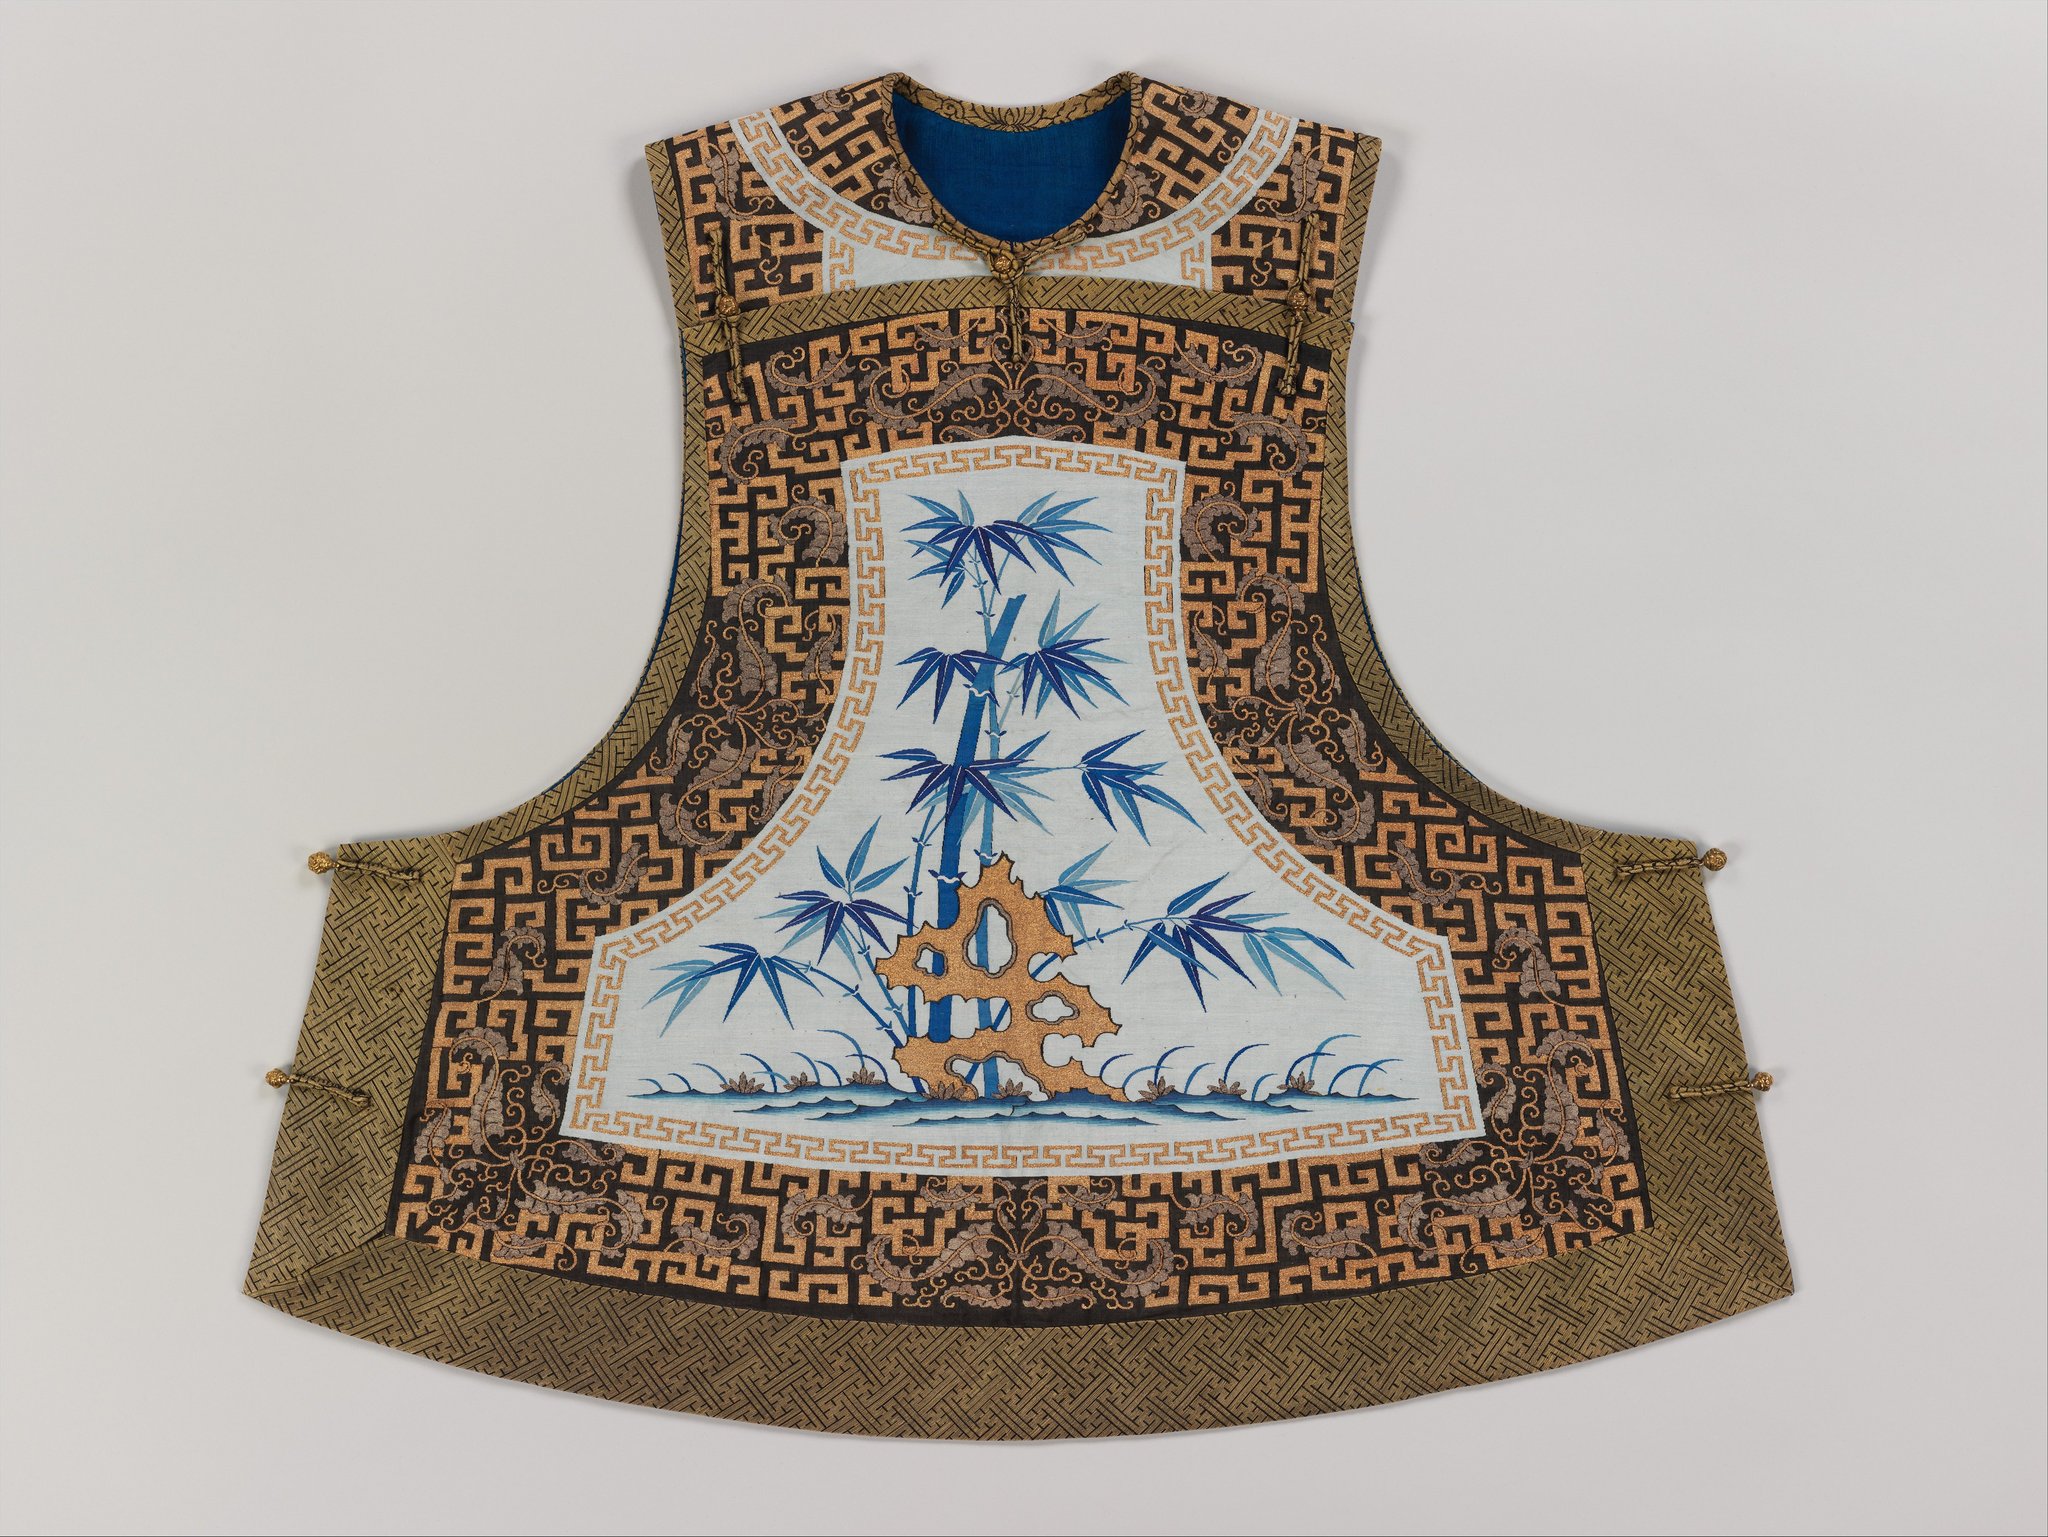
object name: woman's sleeveless jacket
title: Woman's Sleeveless Jacket with Bamboo and Rock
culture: chinese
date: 1867-1900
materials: metal thread, silk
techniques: tapestry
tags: bamboo